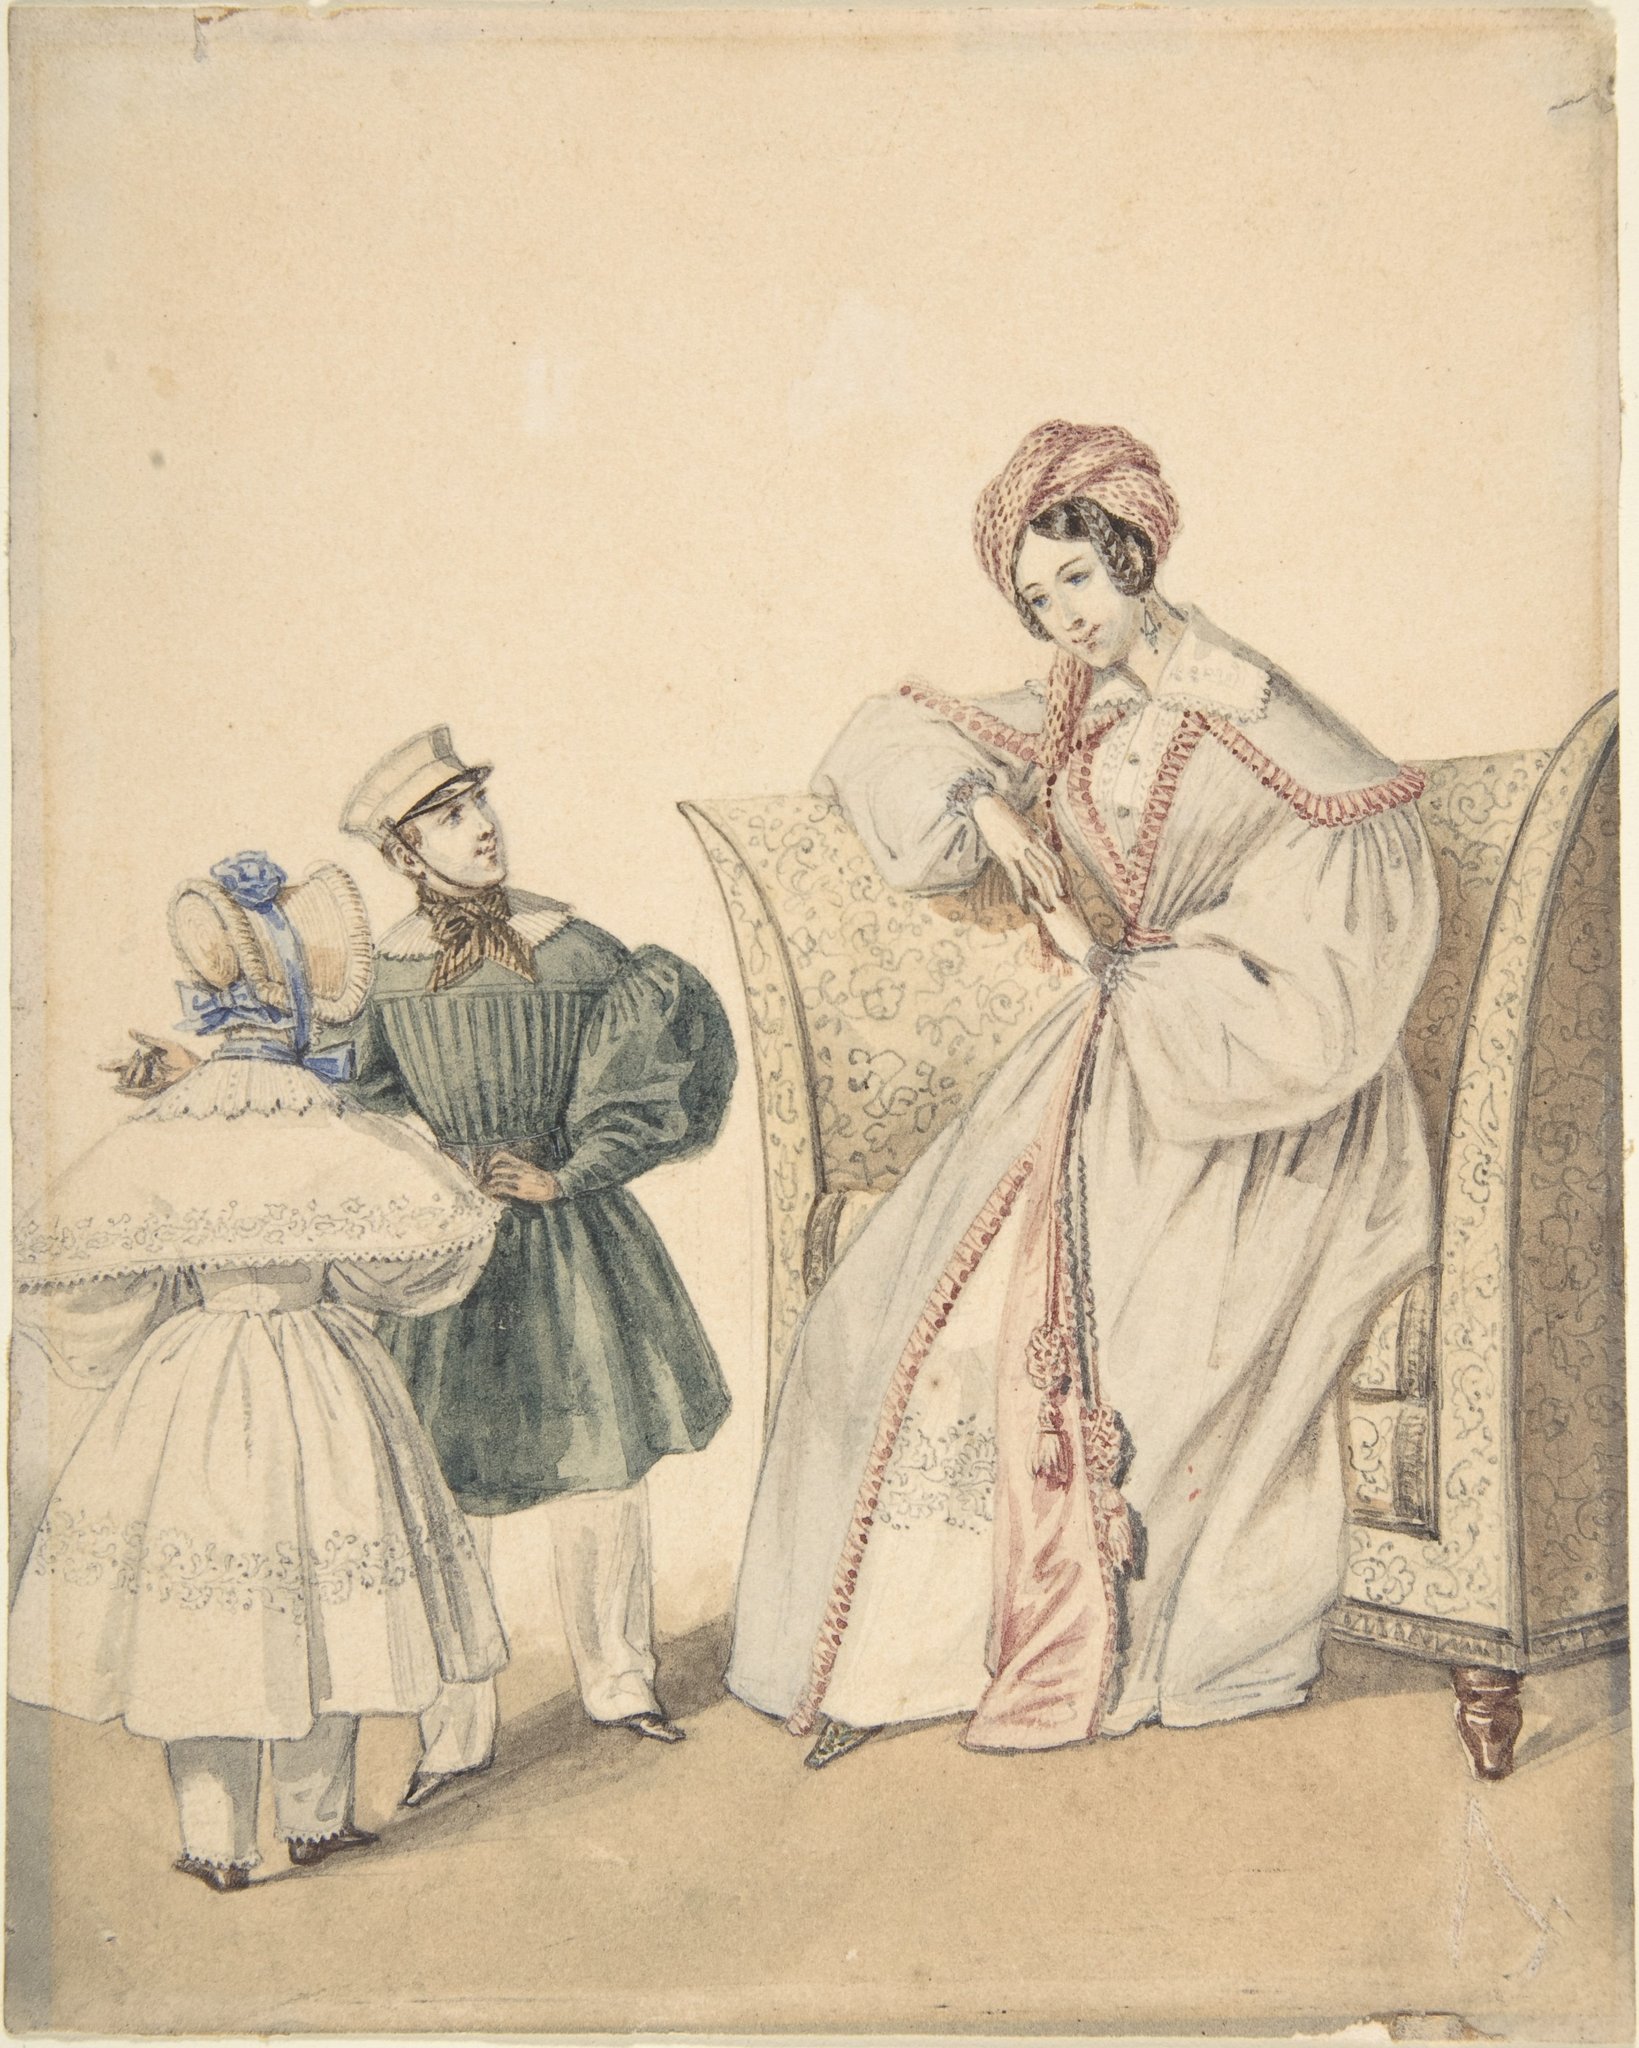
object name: drawing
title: Fashion Drawing with a Woman Seated in a Chair with a Boy and Girl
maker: pierre-numa bassaget, called numa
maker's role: artist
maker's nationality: french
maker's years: 1830-1854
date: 1801-1900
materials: graphite, watercolor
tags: boys,girls,women,chairs